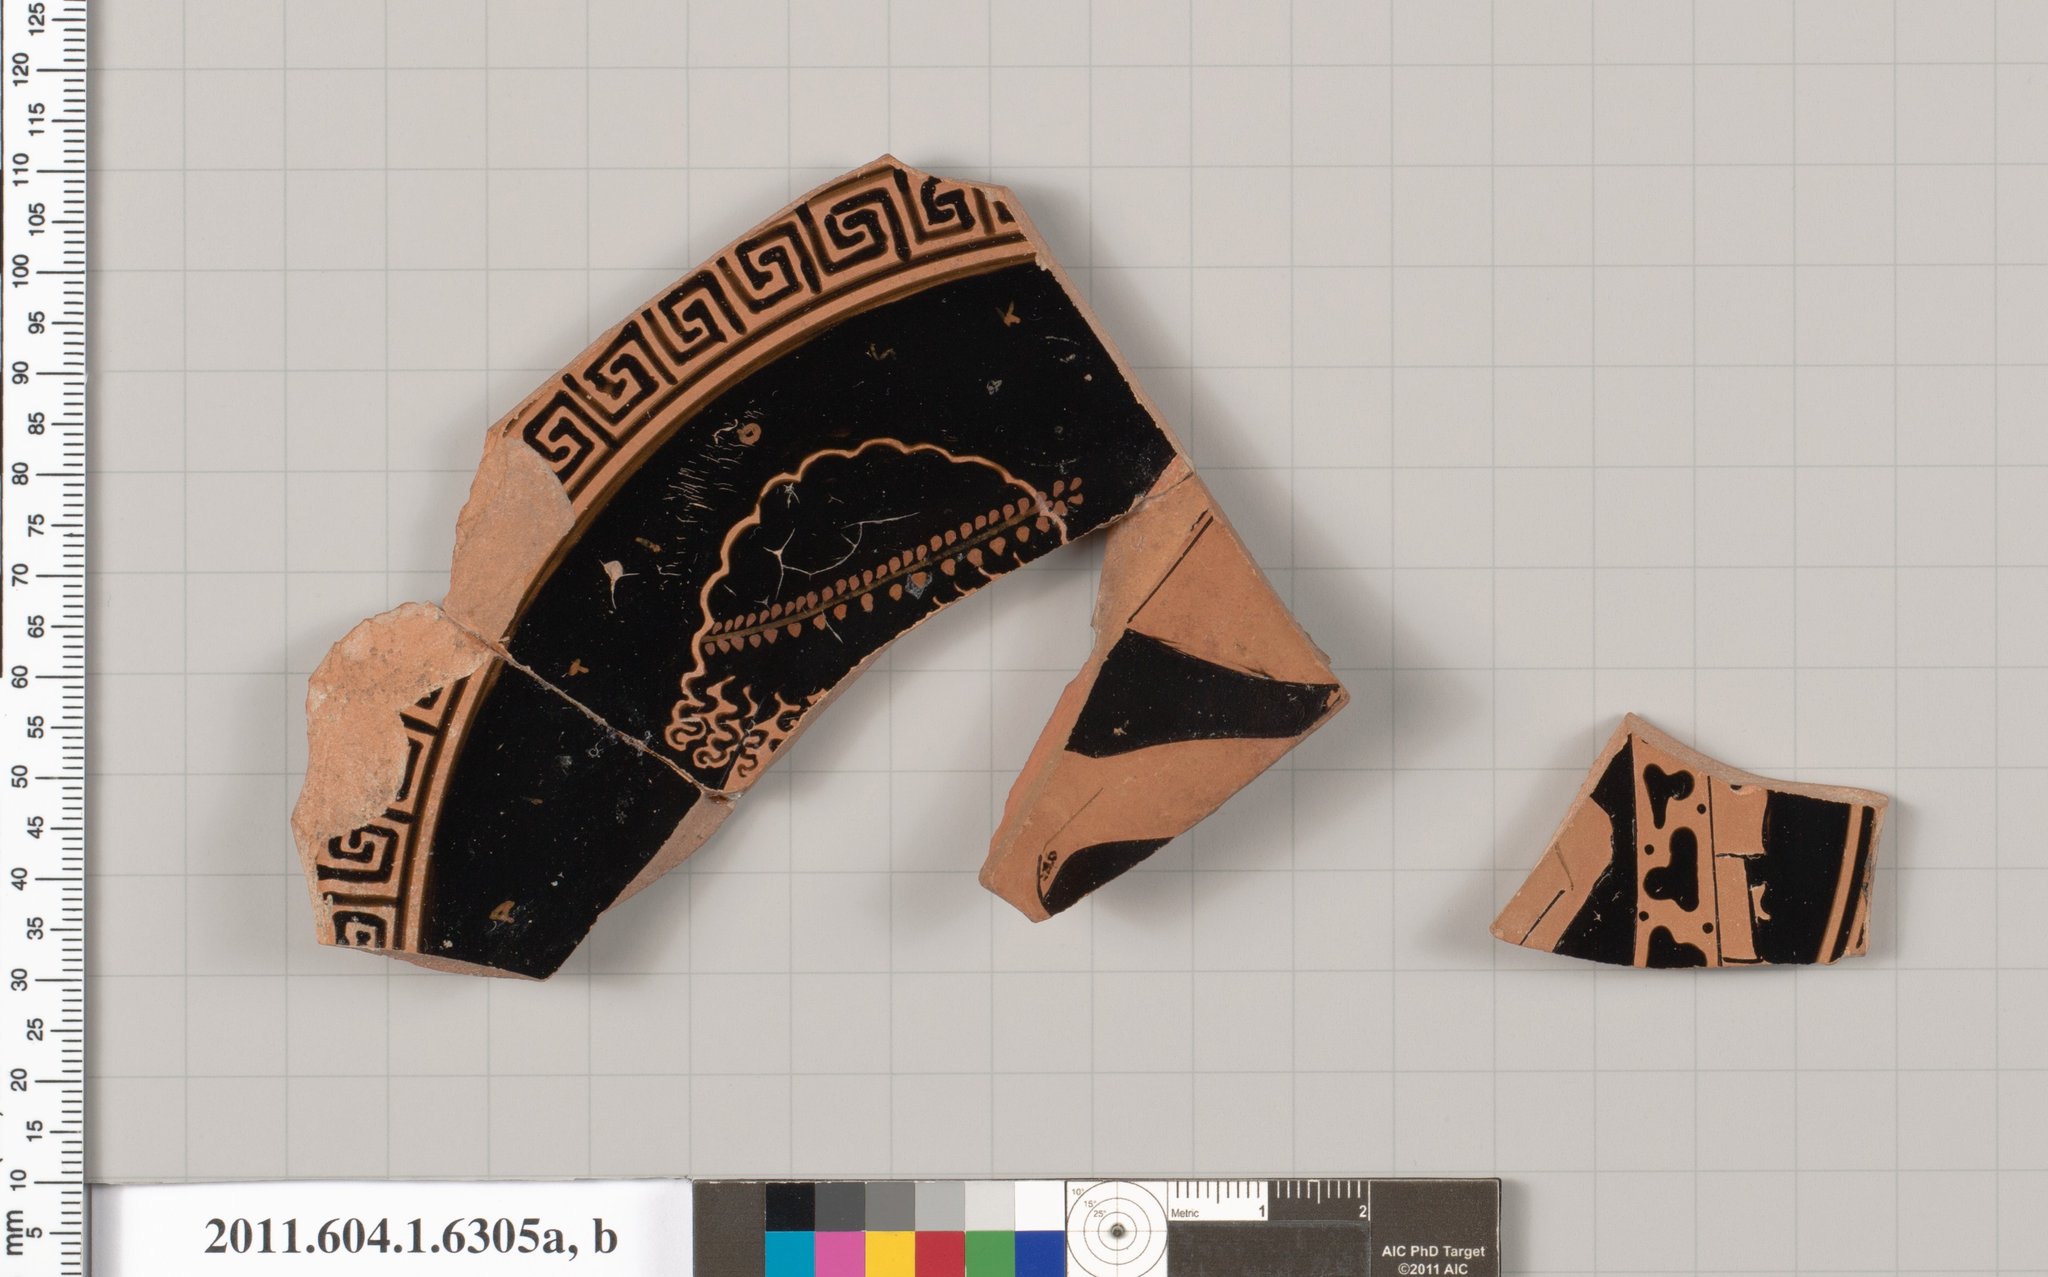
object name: kylix fragment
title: Terracotta fragments of a kylix (drinking cup)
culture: greek, attic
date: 500-480 BCE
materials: terracotta